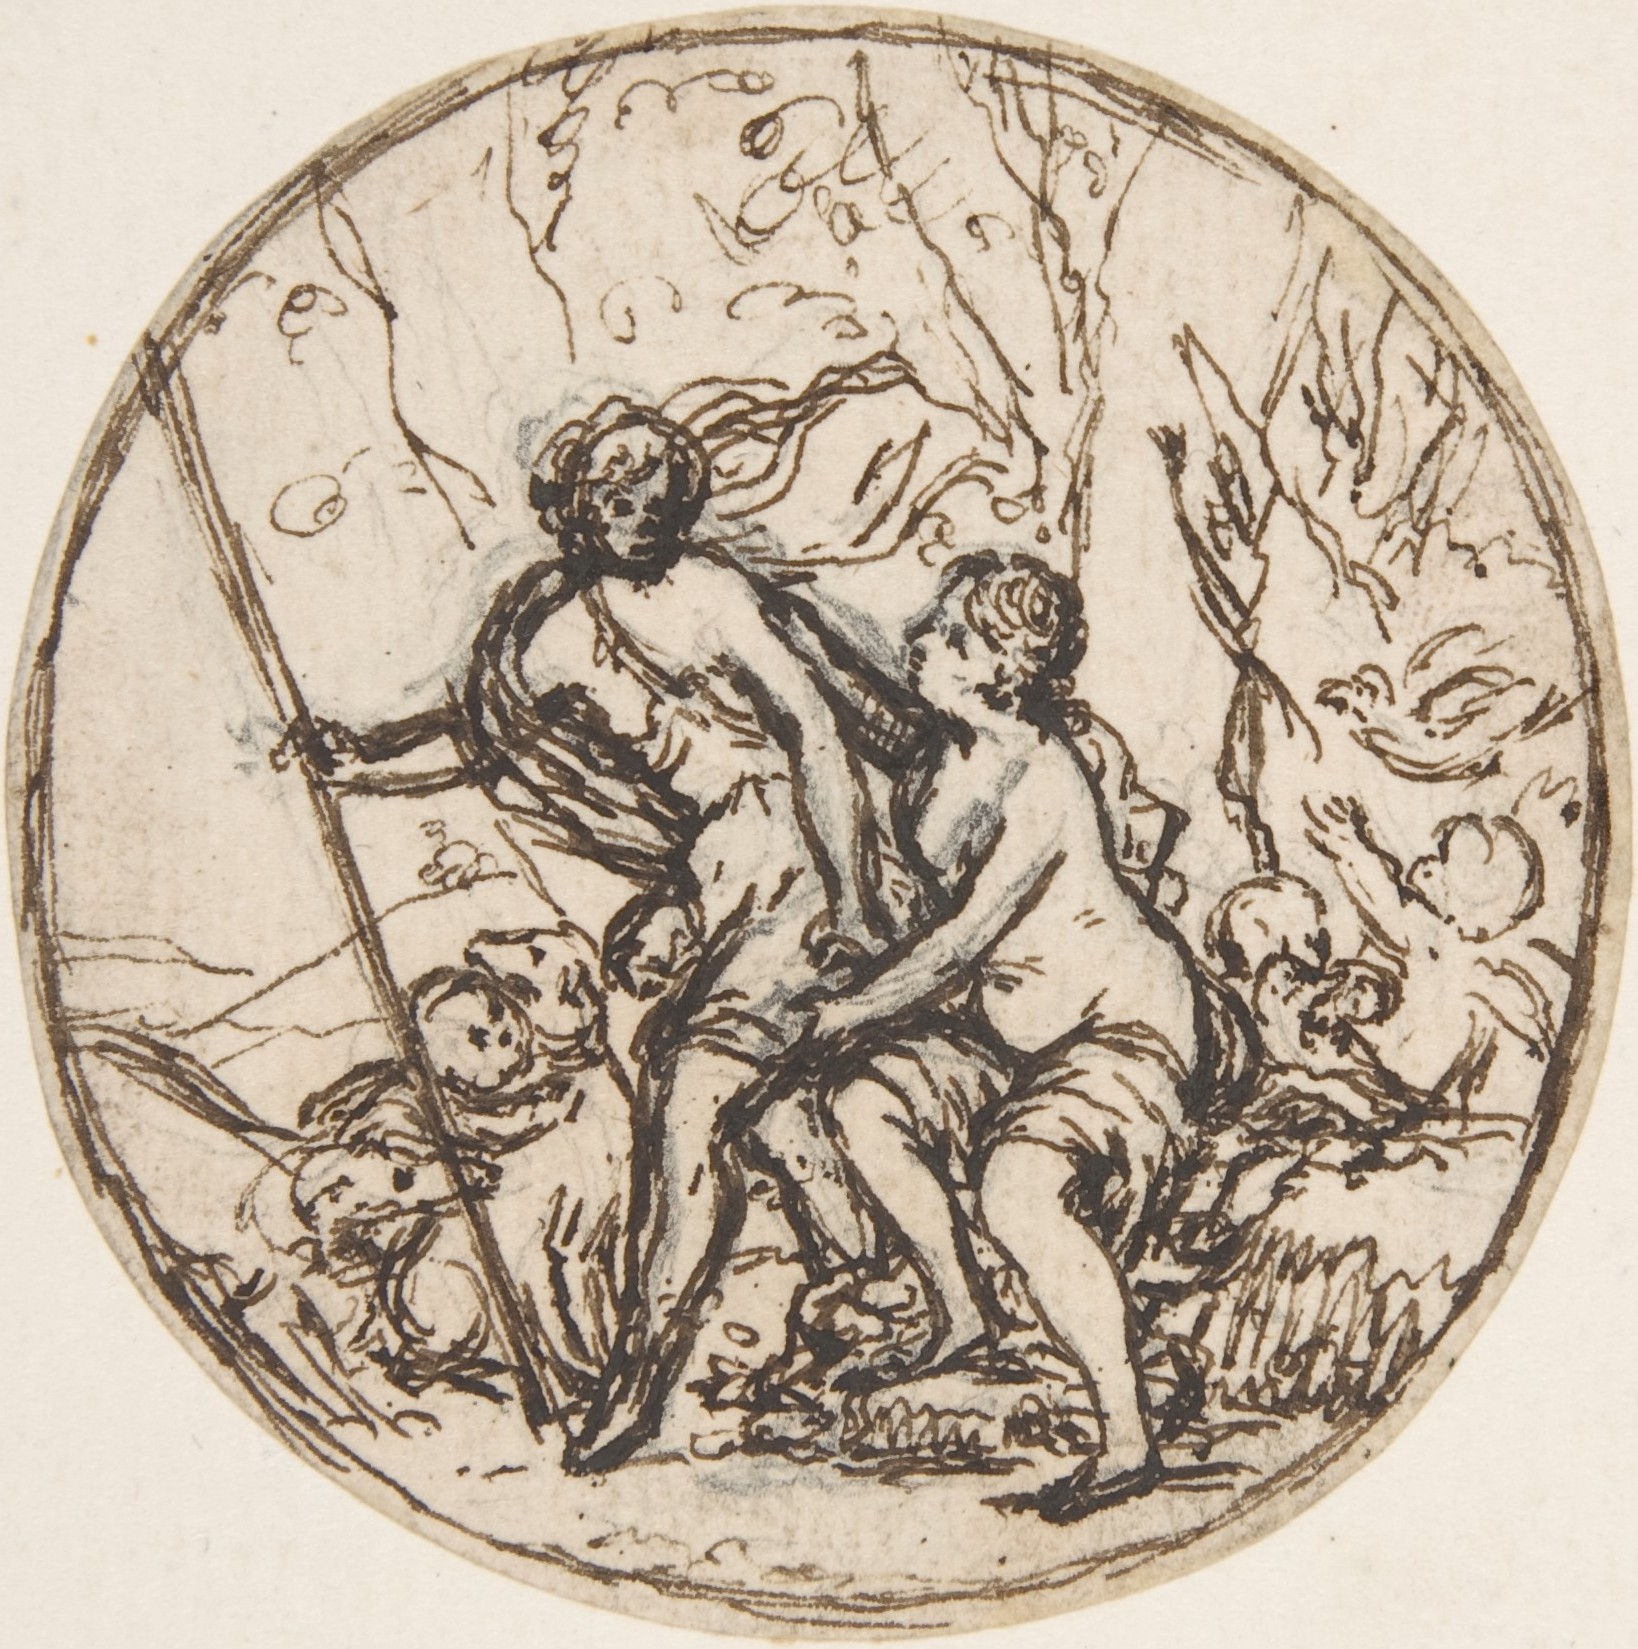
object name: drawing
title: Design for a Box-lid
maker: hubert françois gravelot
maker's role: artist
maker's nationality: french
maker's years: 1699-1773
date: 1699-1773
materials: graphite, ink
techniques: pen, drawing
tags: men,women,dogs